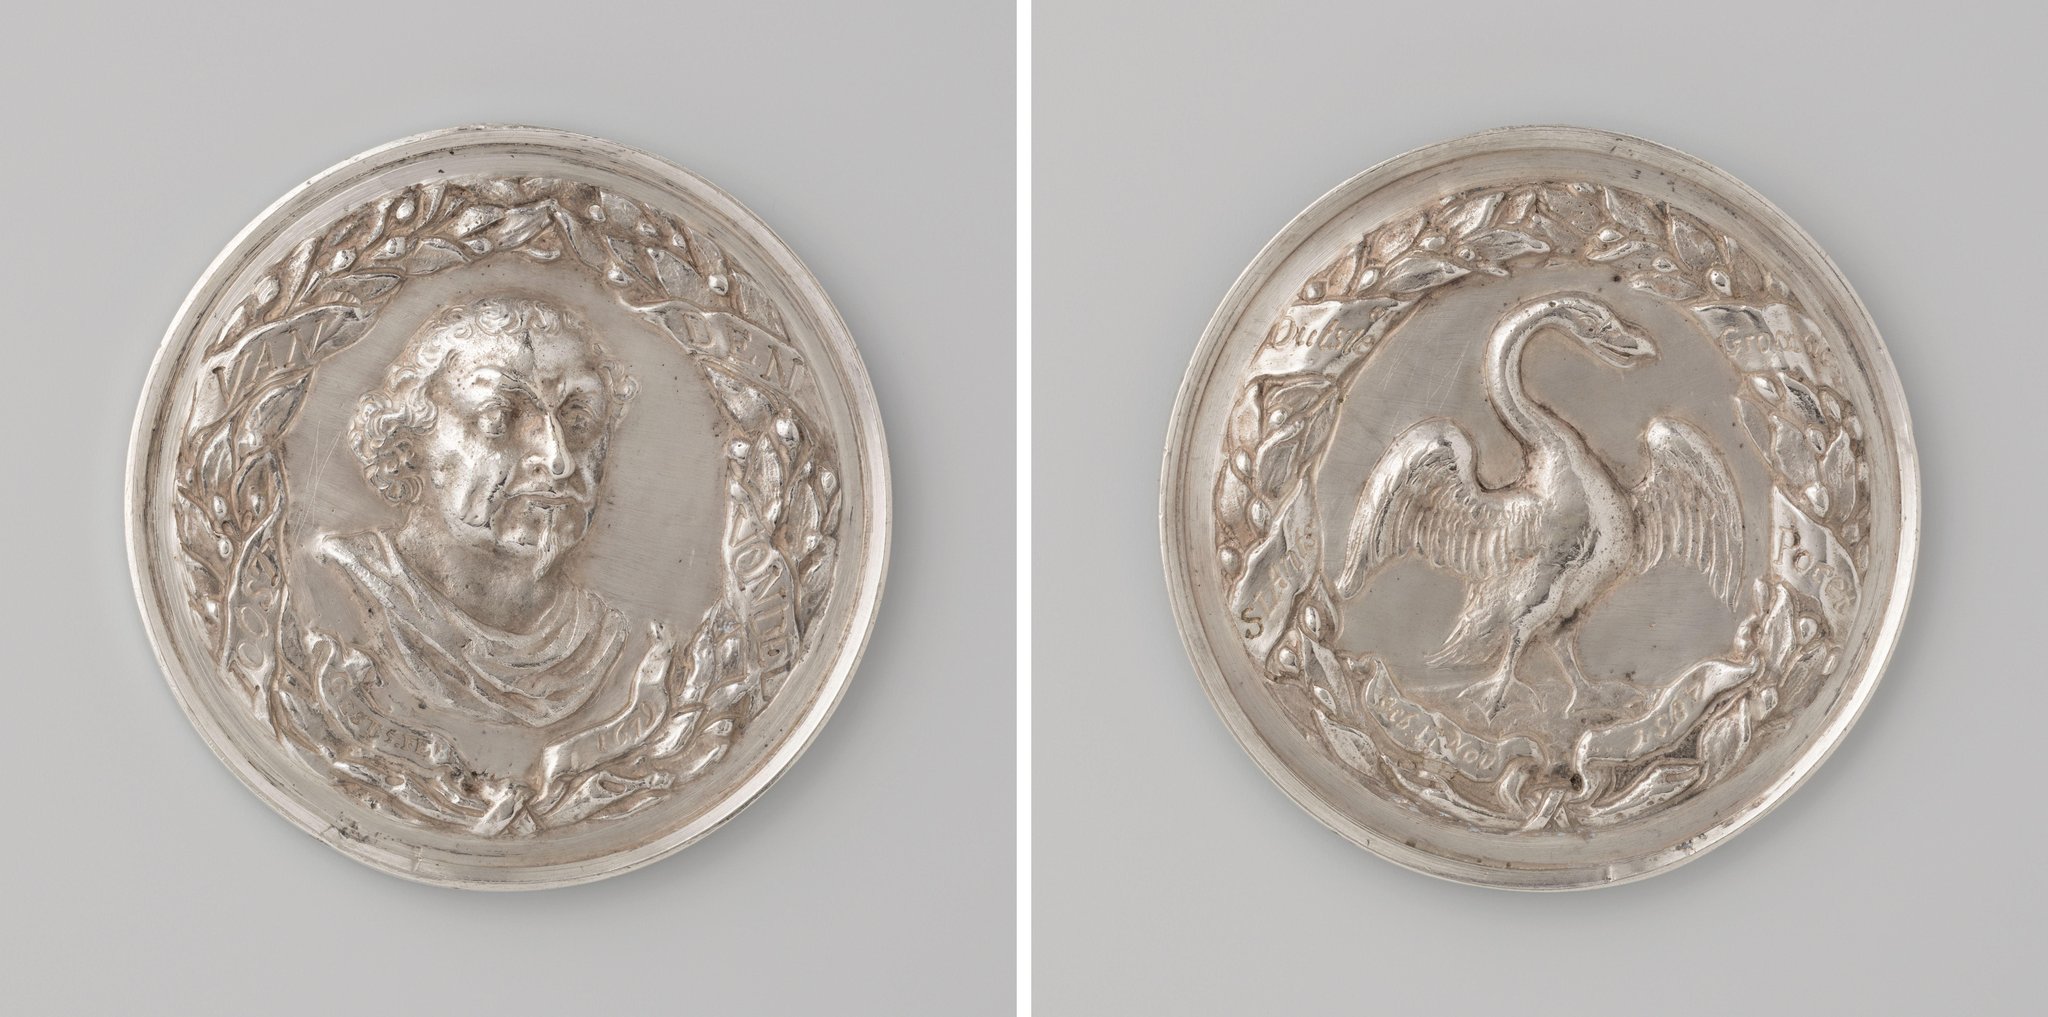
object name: history medal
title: Overlijden van Joost van den Vondel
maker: johannes lutma (1624-1689)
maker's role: print maker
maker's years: 1624-1689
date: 1679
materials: silver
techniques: striking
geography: amsterdam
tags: cologne, joost van den vondel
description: Zilveren penning. Voorzijde: borststuk man binnen met wimpel omwonden lauwerkrans. Keerzijde: zwaan binnen met wimpel omwonden lauwerkrans